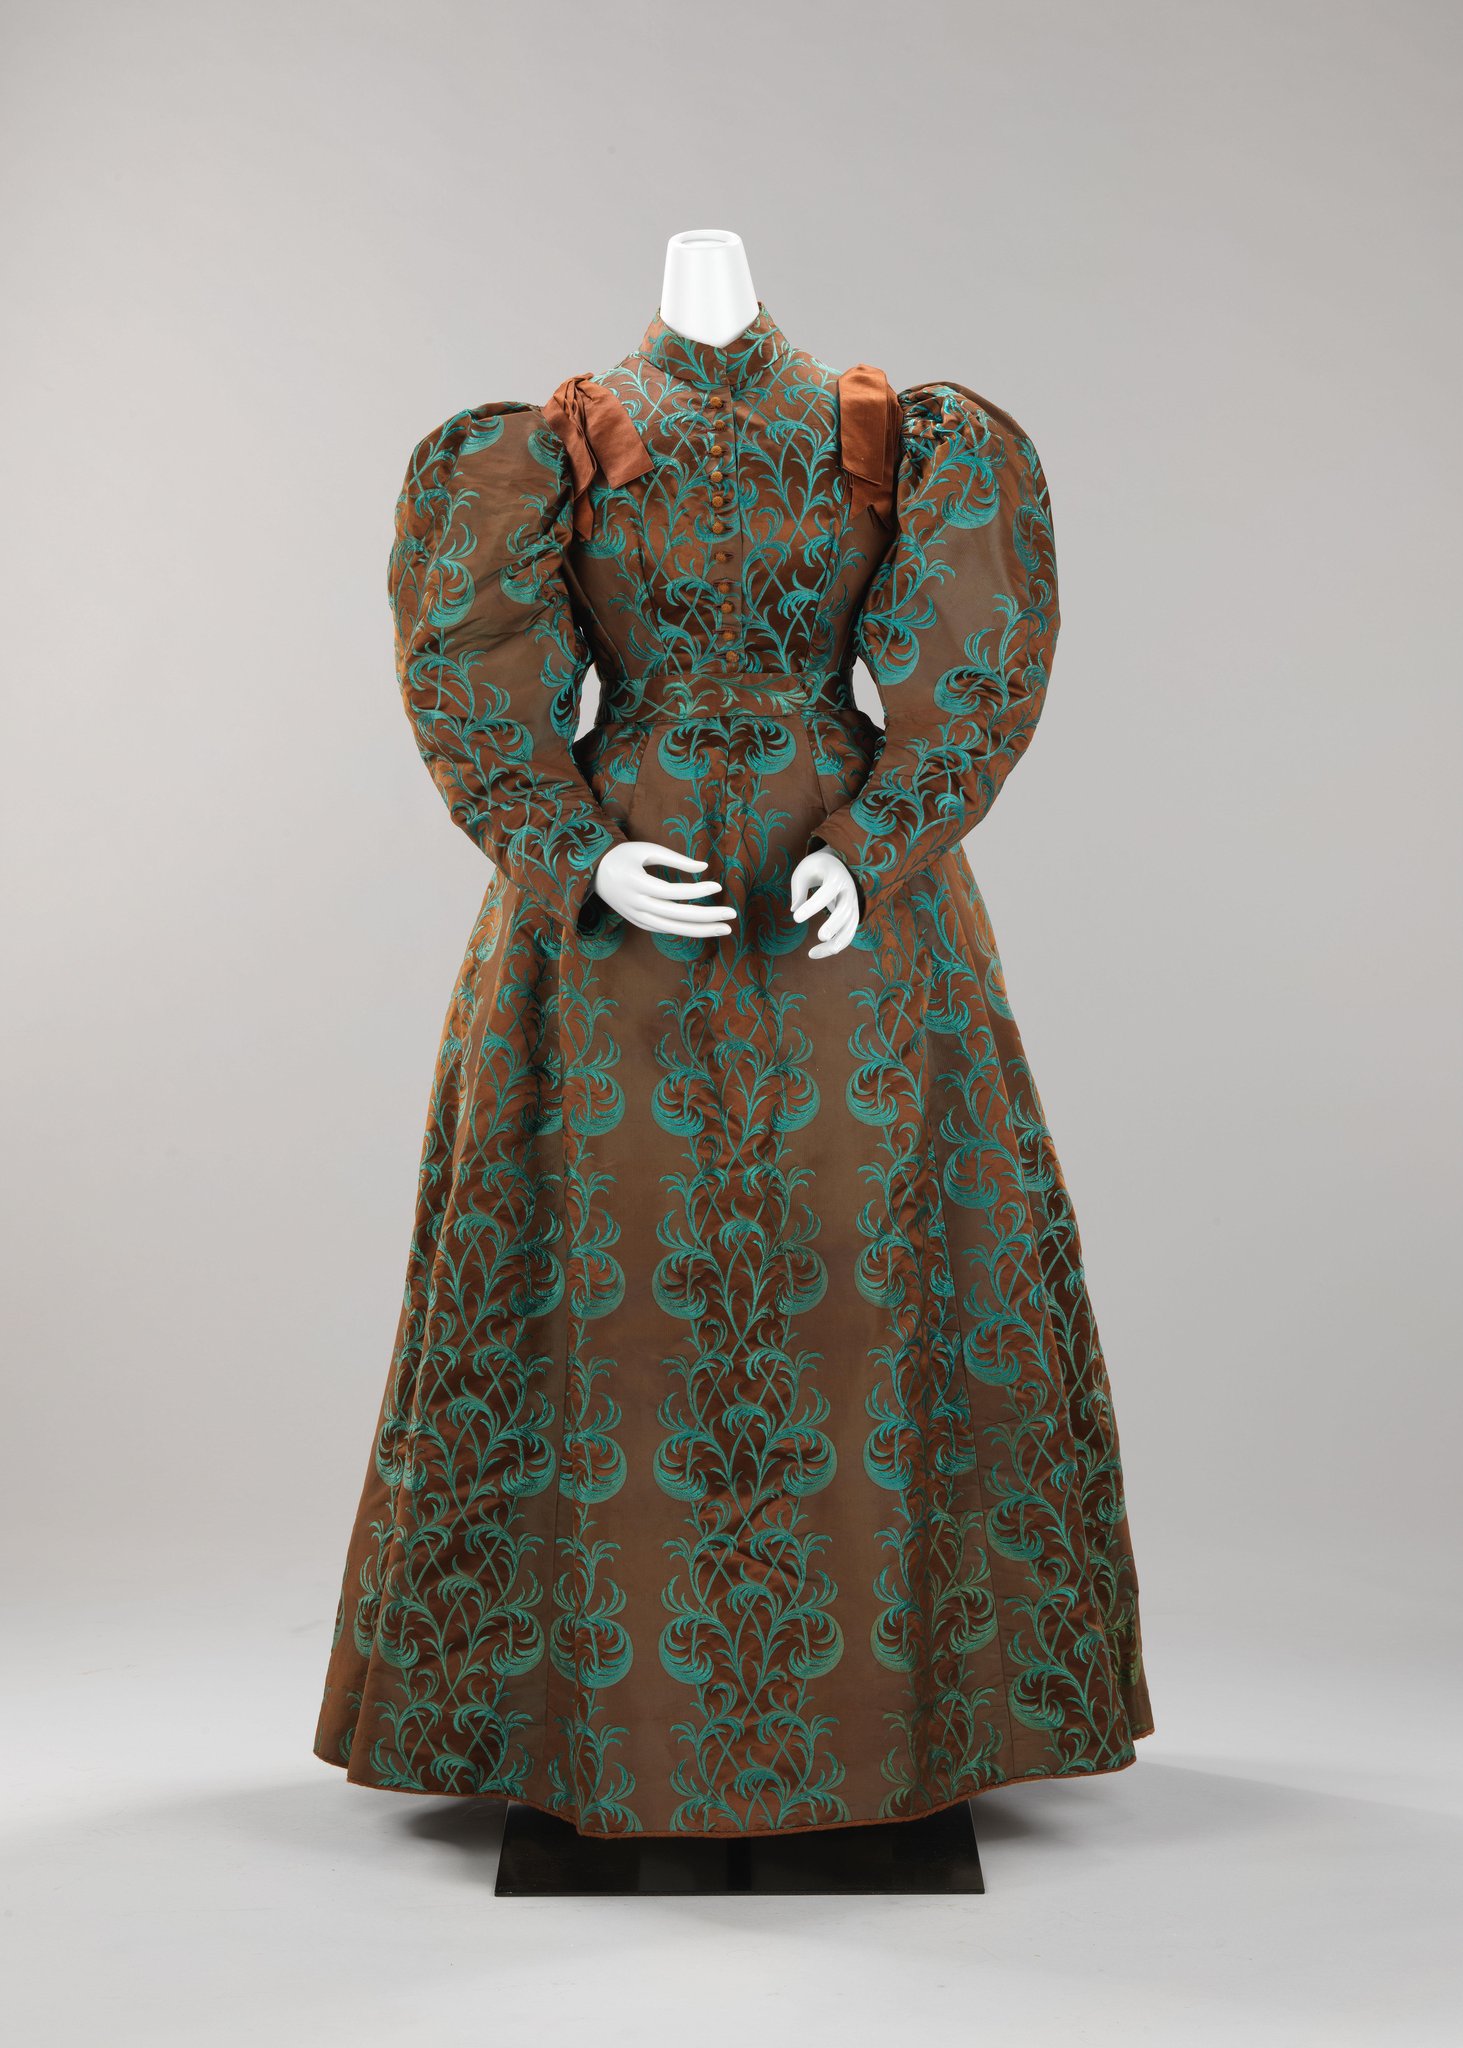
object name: main garment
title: Japon met lange pofmouw, knoopsluiting, ceintuur en staande kraag van bruine zijde met blauwgroene struisveermotieven; op de schouders een bruine satijnen strik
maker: Anonymous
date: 1895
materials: cotton, textile, silk